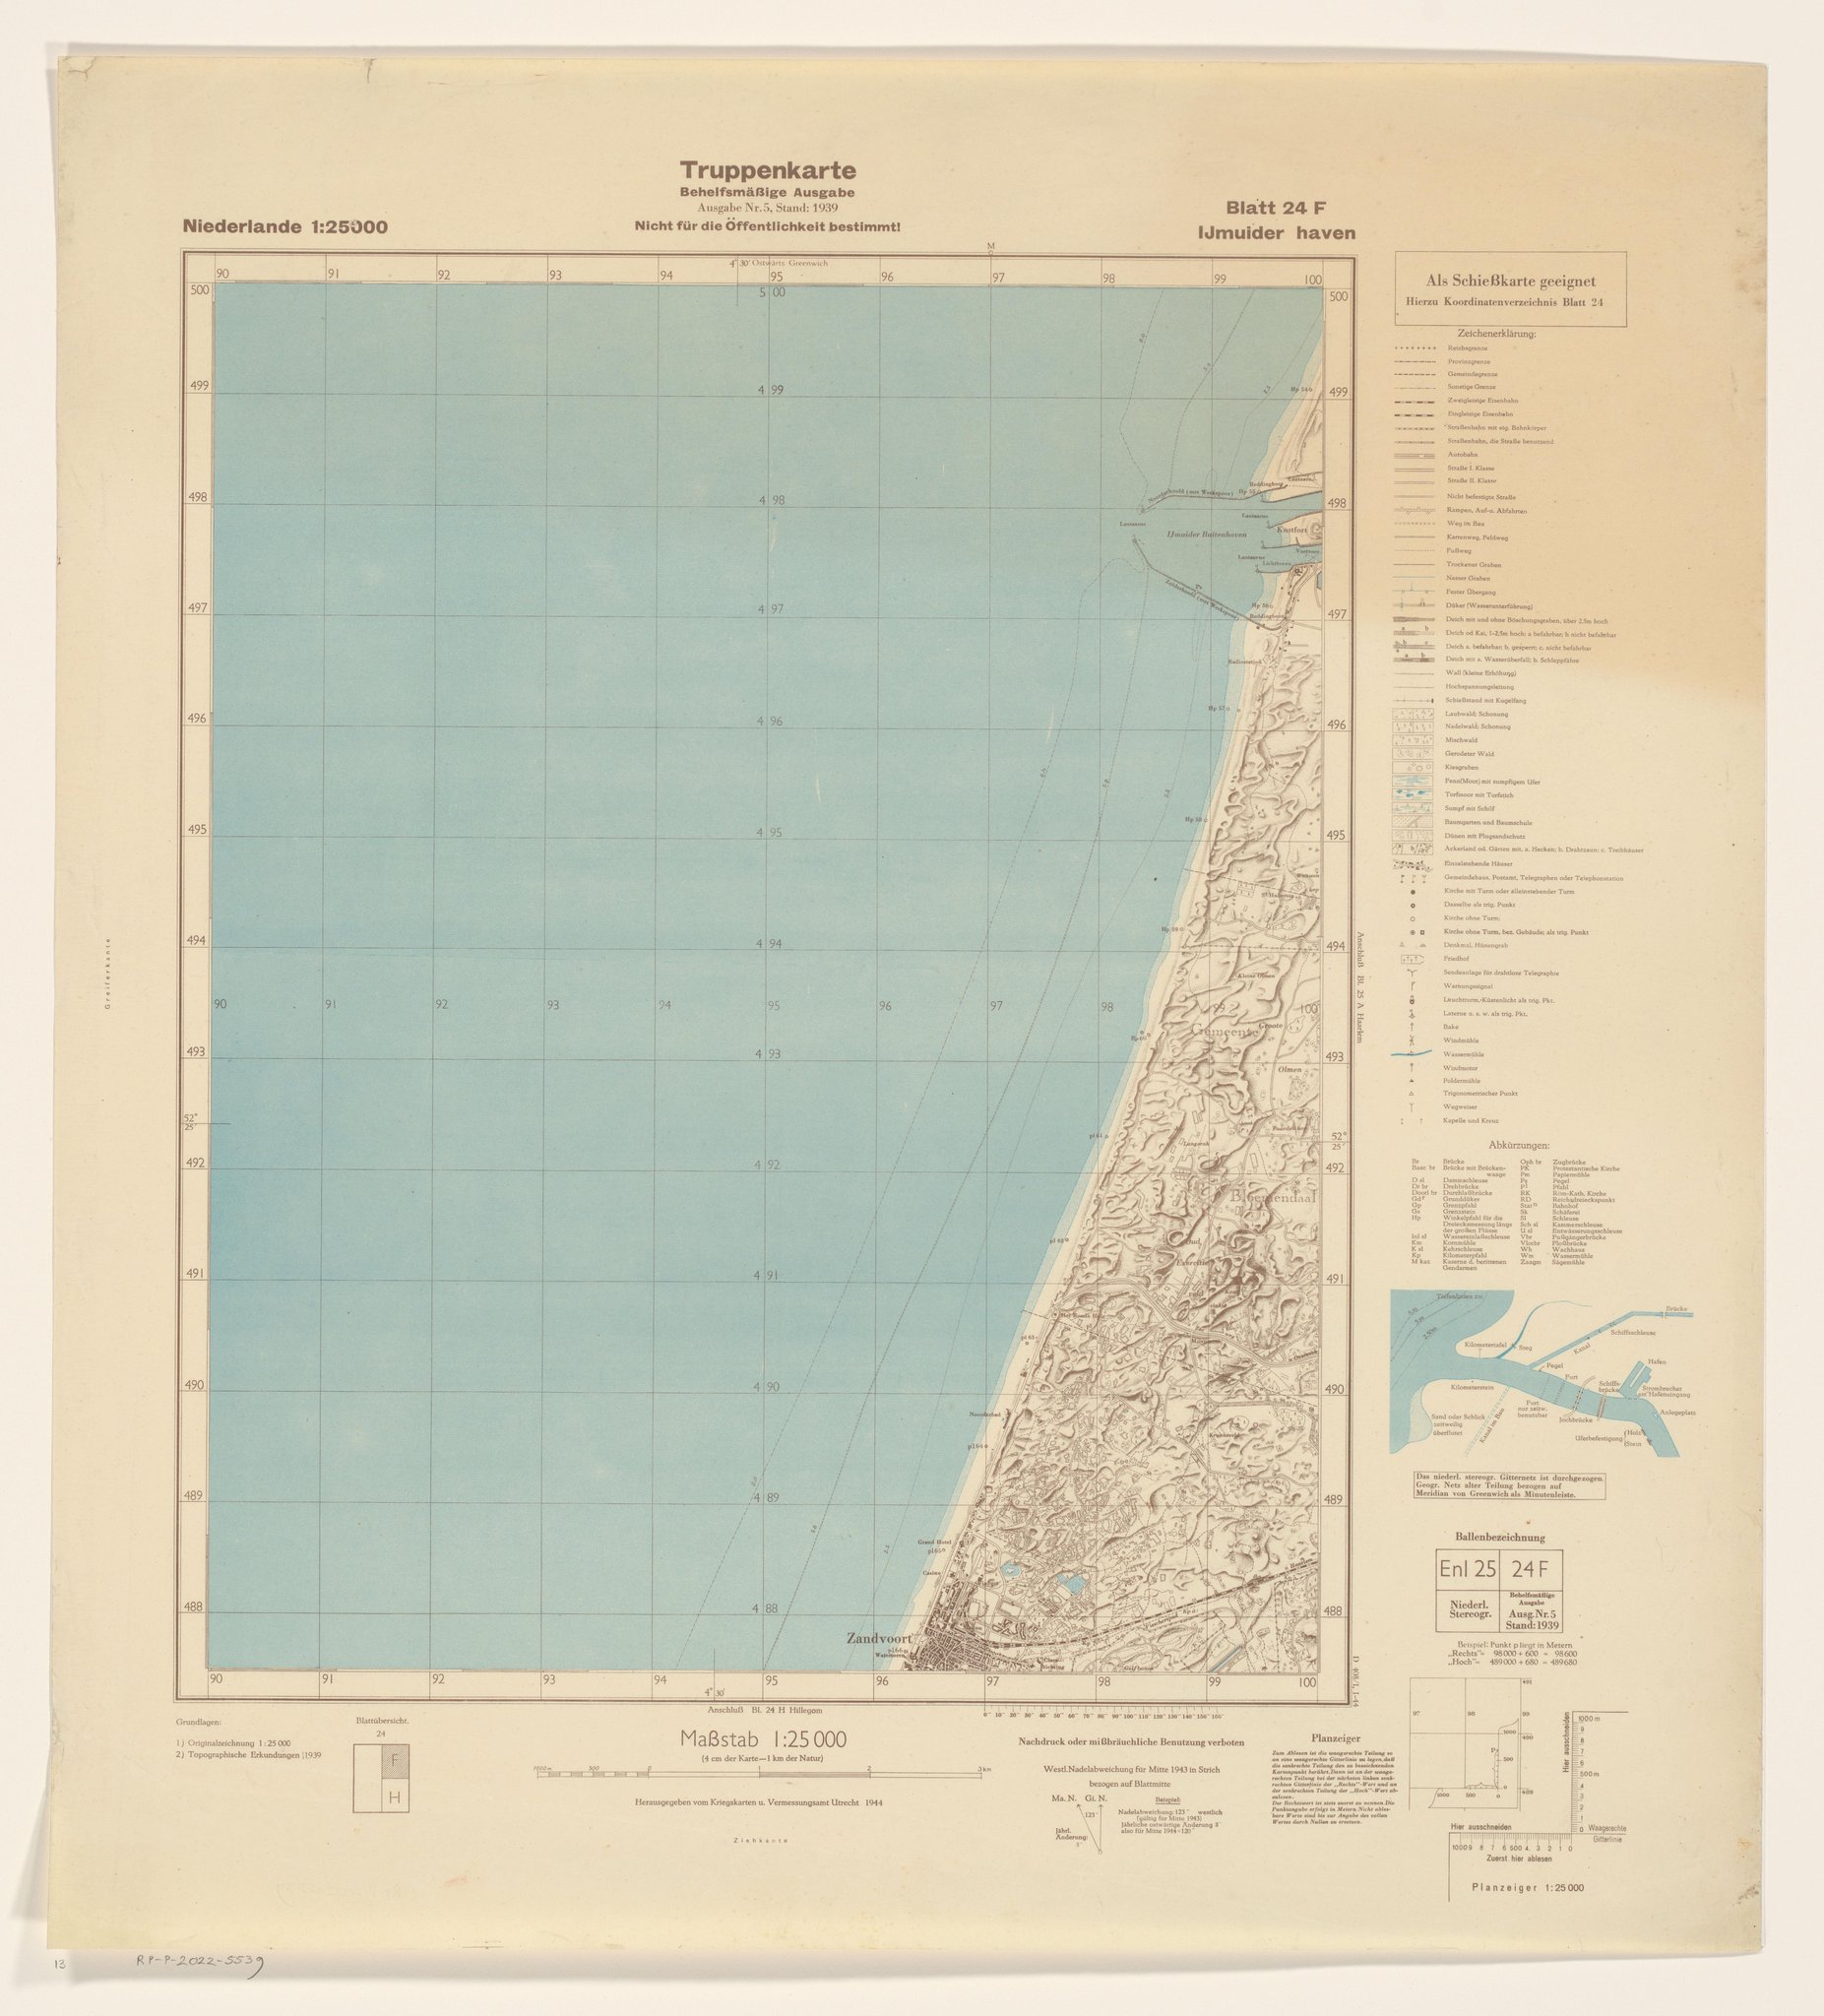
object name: map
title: Duitse militaire kaart van het kustgebied tussen IJmuiden en Zandvoort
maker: Anonymous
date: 1944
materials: paper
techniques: lithograph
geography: netherlands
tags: maps of separate countries or regions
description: Duitse militaire kaart van het kustgebied tussen de haven van IJmuiden en Zandvoort. Aan de rechterzijde de legenda. Schaal 1 : 25000.